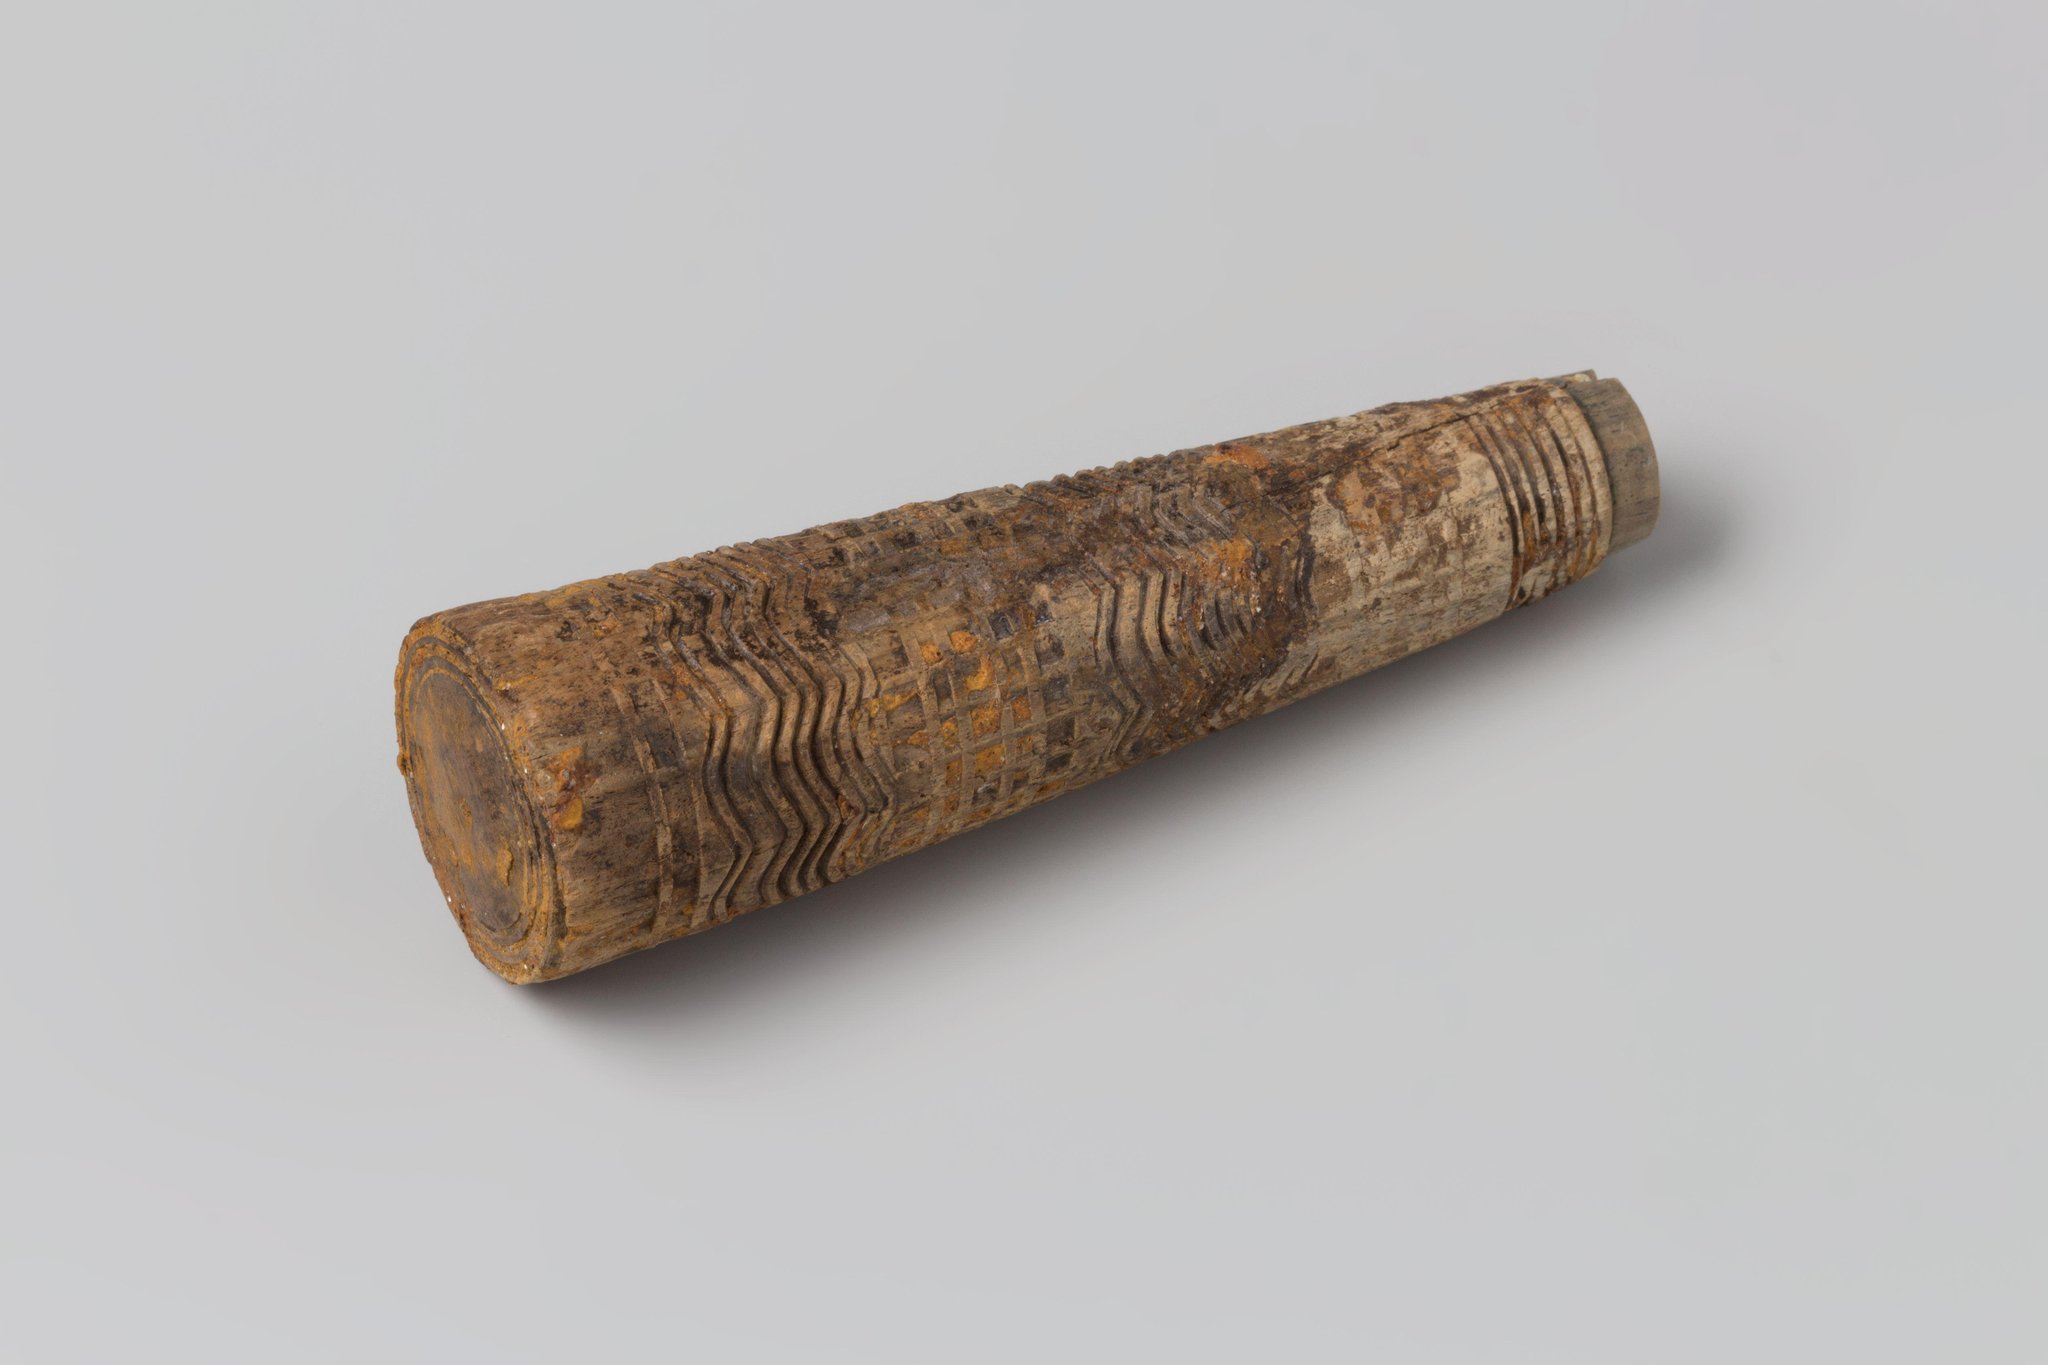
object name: knife handle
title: Messenheft uit het wrak van de Oost-Indiëvaarder Hollandia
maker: Anonymous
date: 1700-1743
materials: wood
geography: netherlands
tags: verenigde oostindische compagnie, hollandia (schip), annet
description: Knife, handle, cylindrical: tapering; id. NG 1979-403H, ferrules, id. NG 1980-27H426.